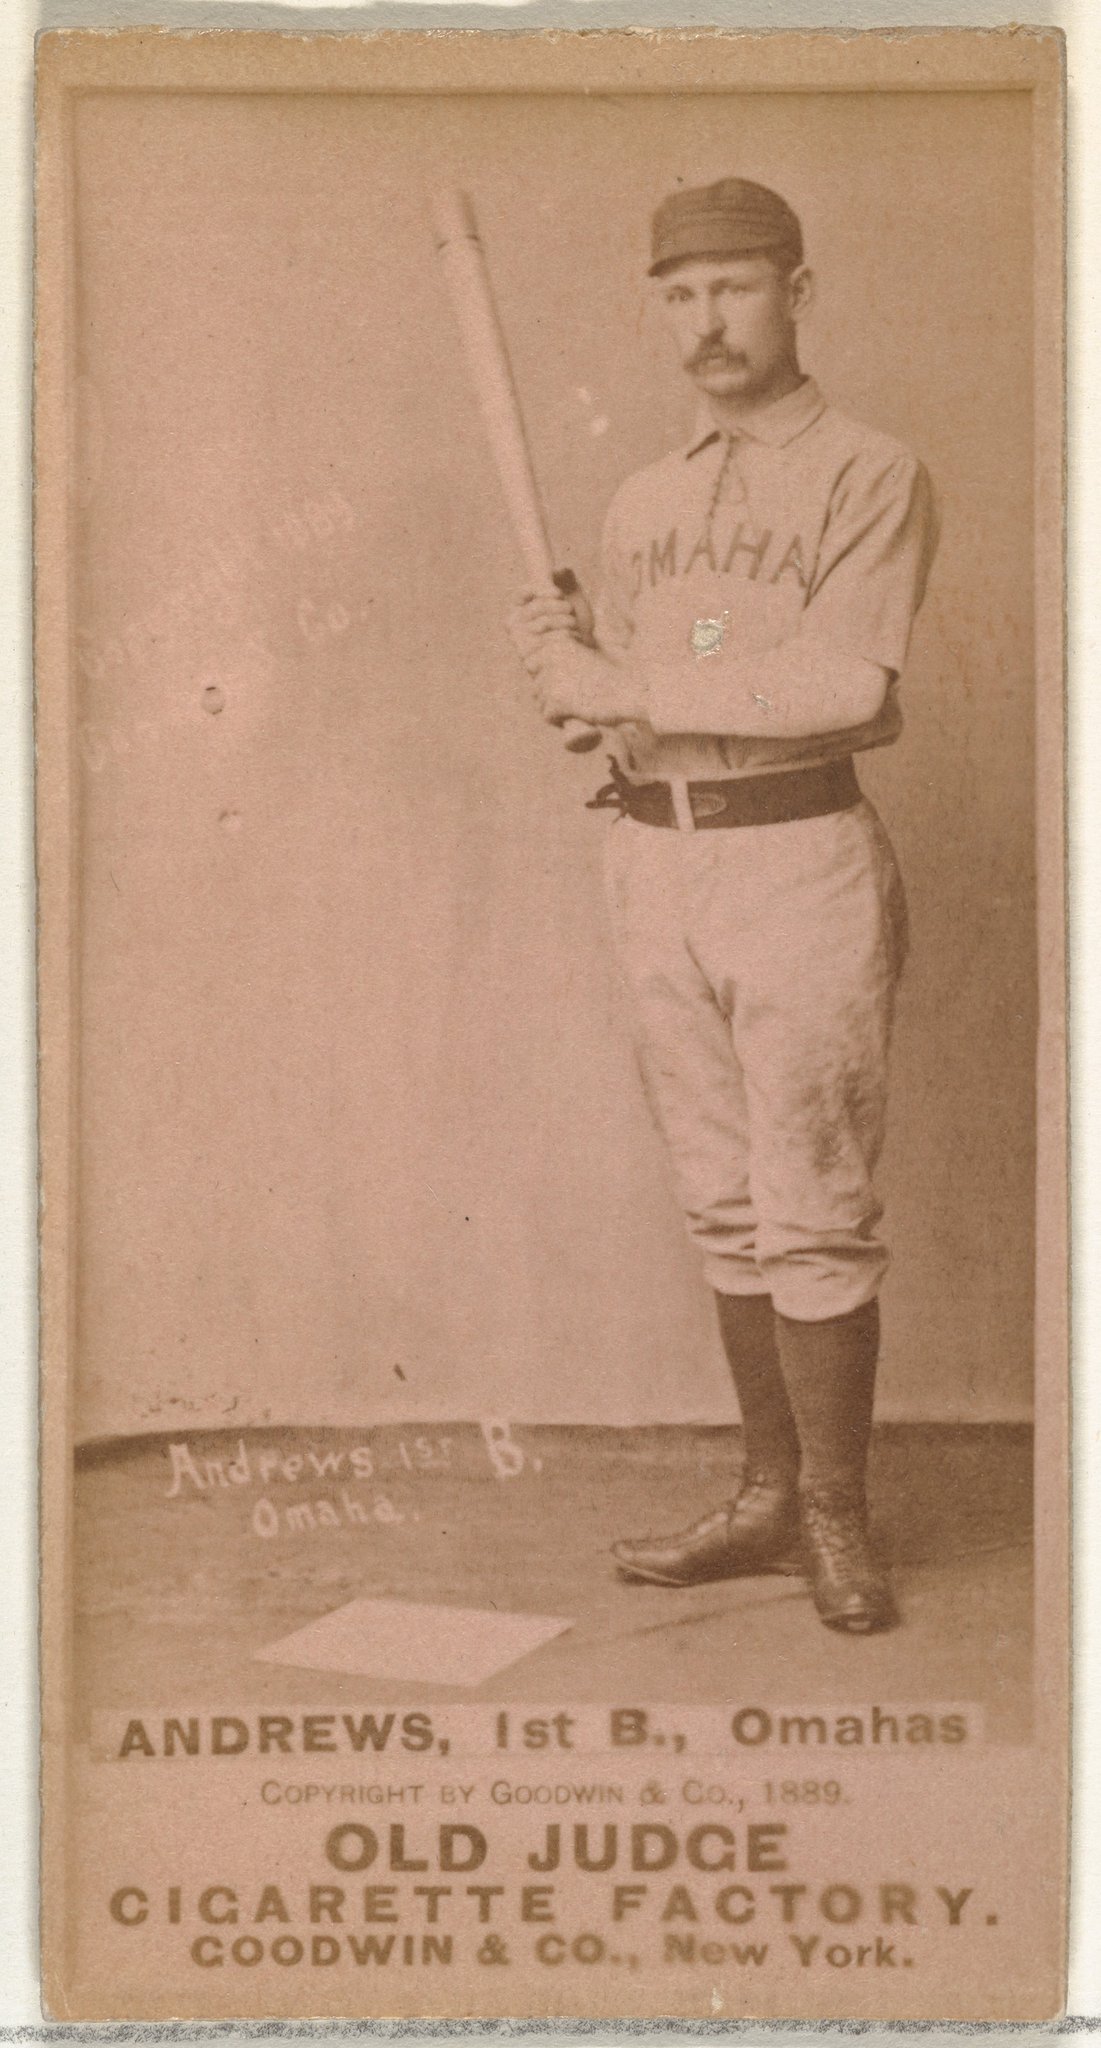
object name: baseball card, photograph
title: William Walter "Wally" Andrews, 1st Base, Omaha Omahogs/Lambs, from the Old Judge series (N172) for Old Judge Cigarettes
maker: goodwin & company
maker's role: publisher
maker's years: 1850-1950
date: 1889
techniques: albumen silver print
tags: men,portraits,baseball,athletes